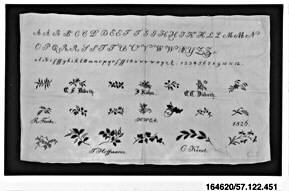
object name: sampler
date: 1826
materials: cotton, linen